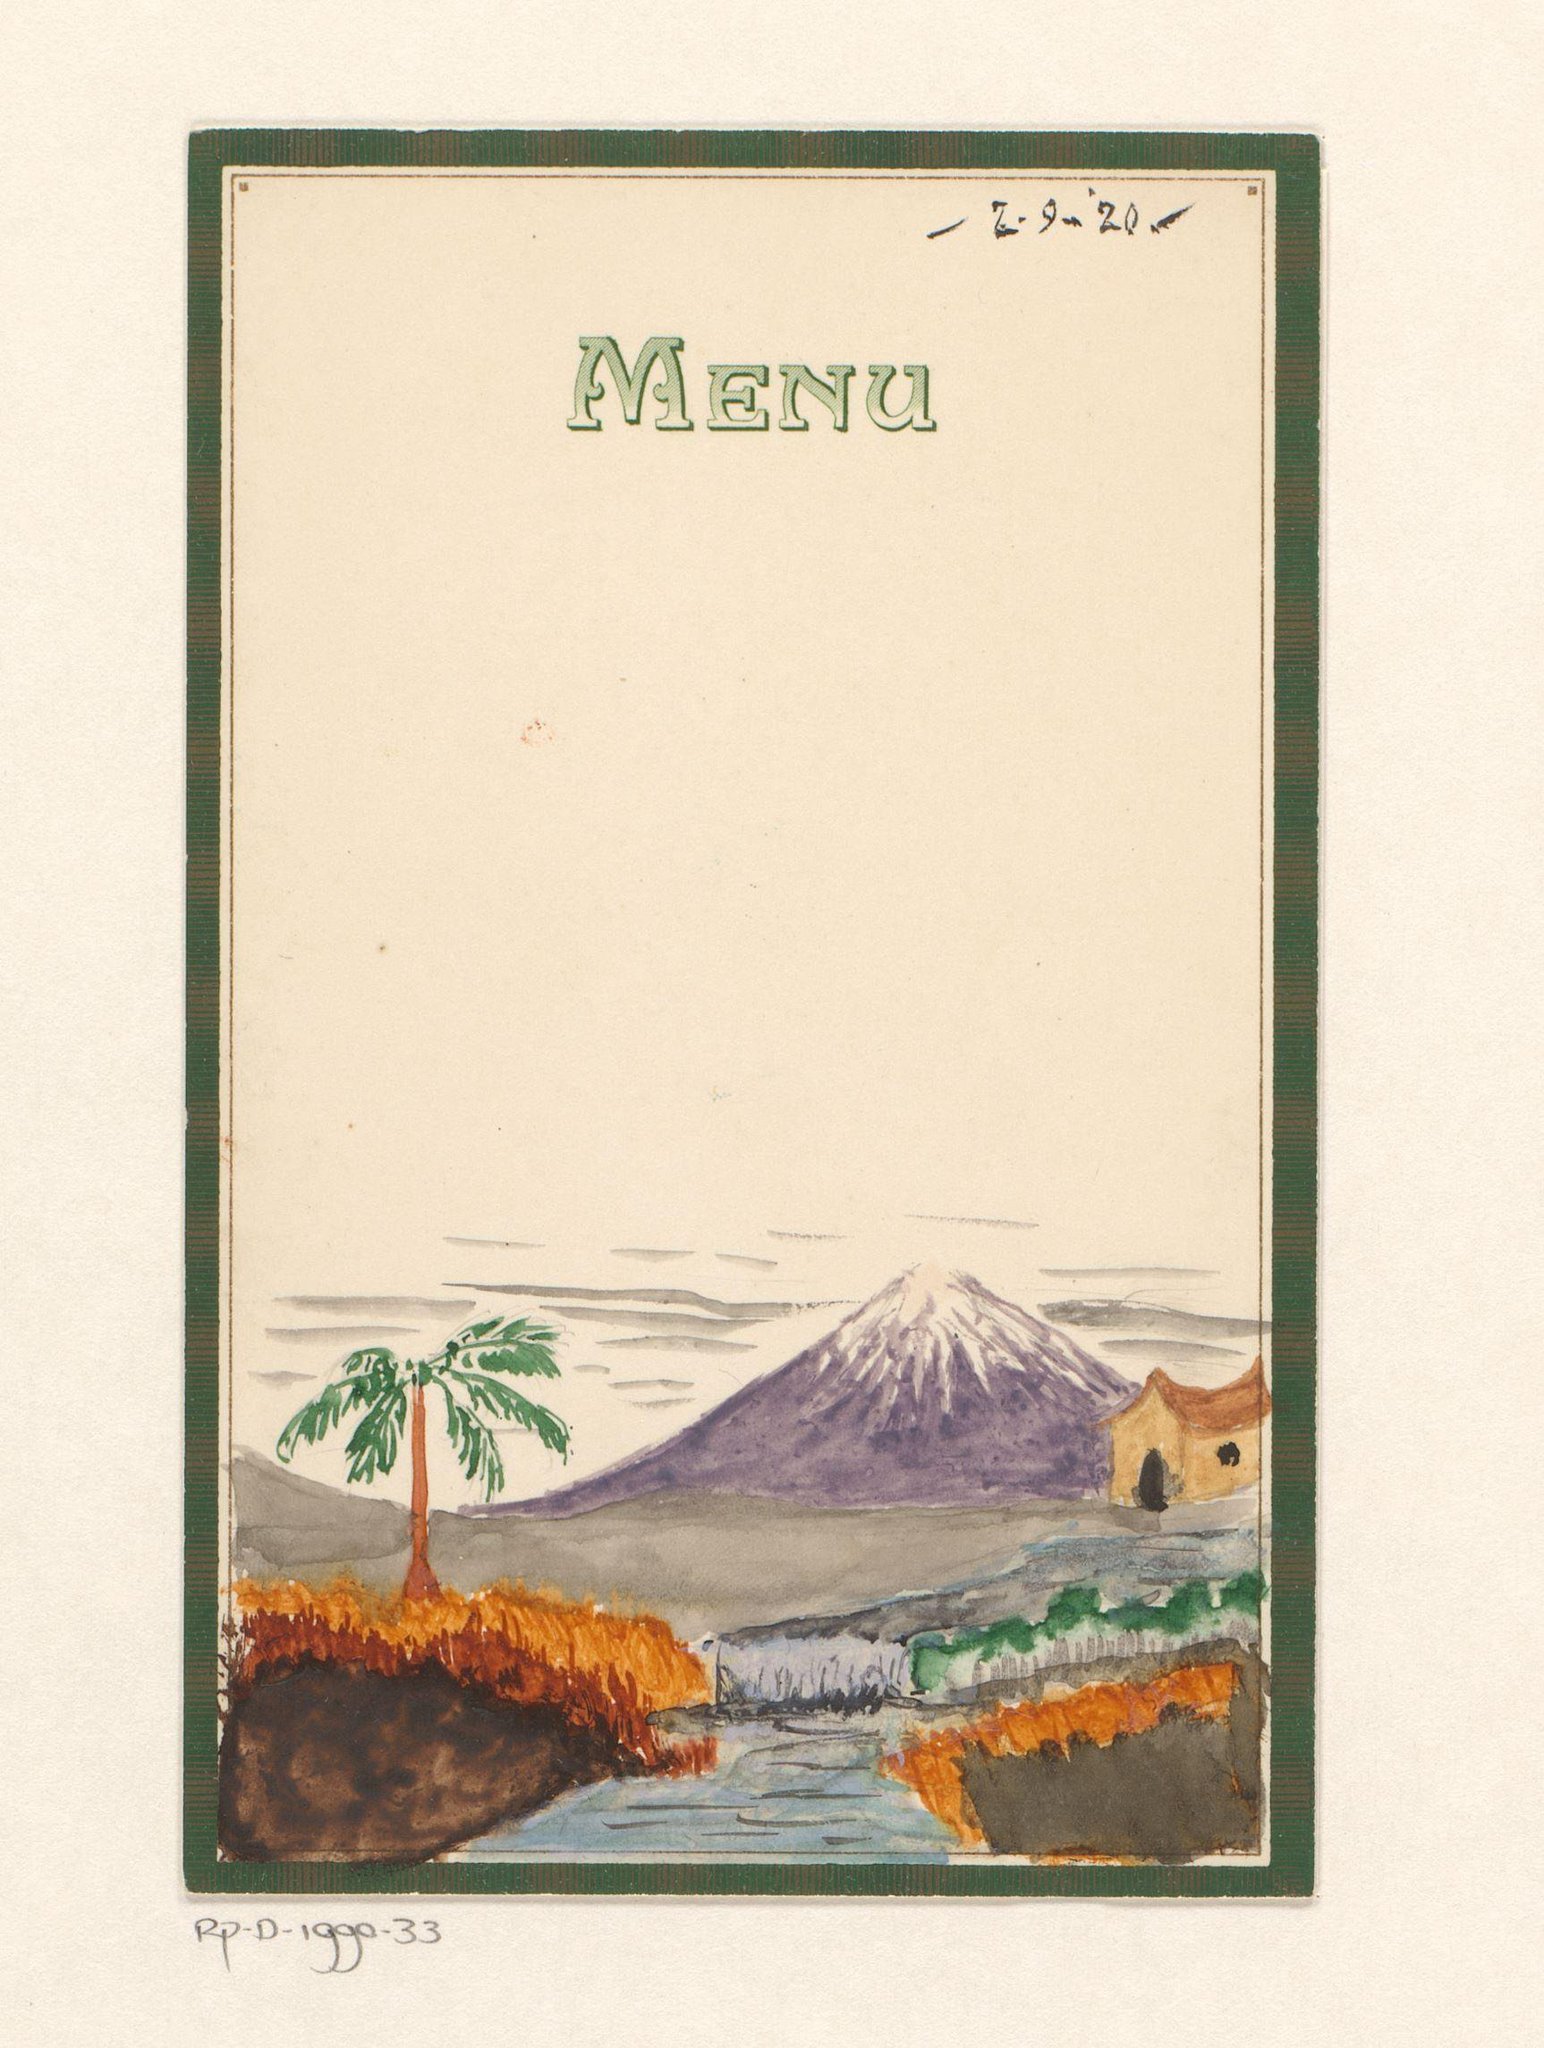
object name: photomechanical print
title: Menukaart voor een diner op 2 september 1920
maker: Anonymous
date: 1920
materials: paper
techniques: brush, printing block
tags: mountains (in tropical and sub-tropical regions)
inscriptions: collector's mark: Lugt 2228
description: Rechtsboven in handschrift '2-9-'20' boven 'Menu' met daaronder ruimte om het menu met de hand in te vullen. Dat is op dit exemplaar niet gebeurd. Wel is onderaan het blad een landschap met palmboom en besneeuwde bergtop geschilderd.